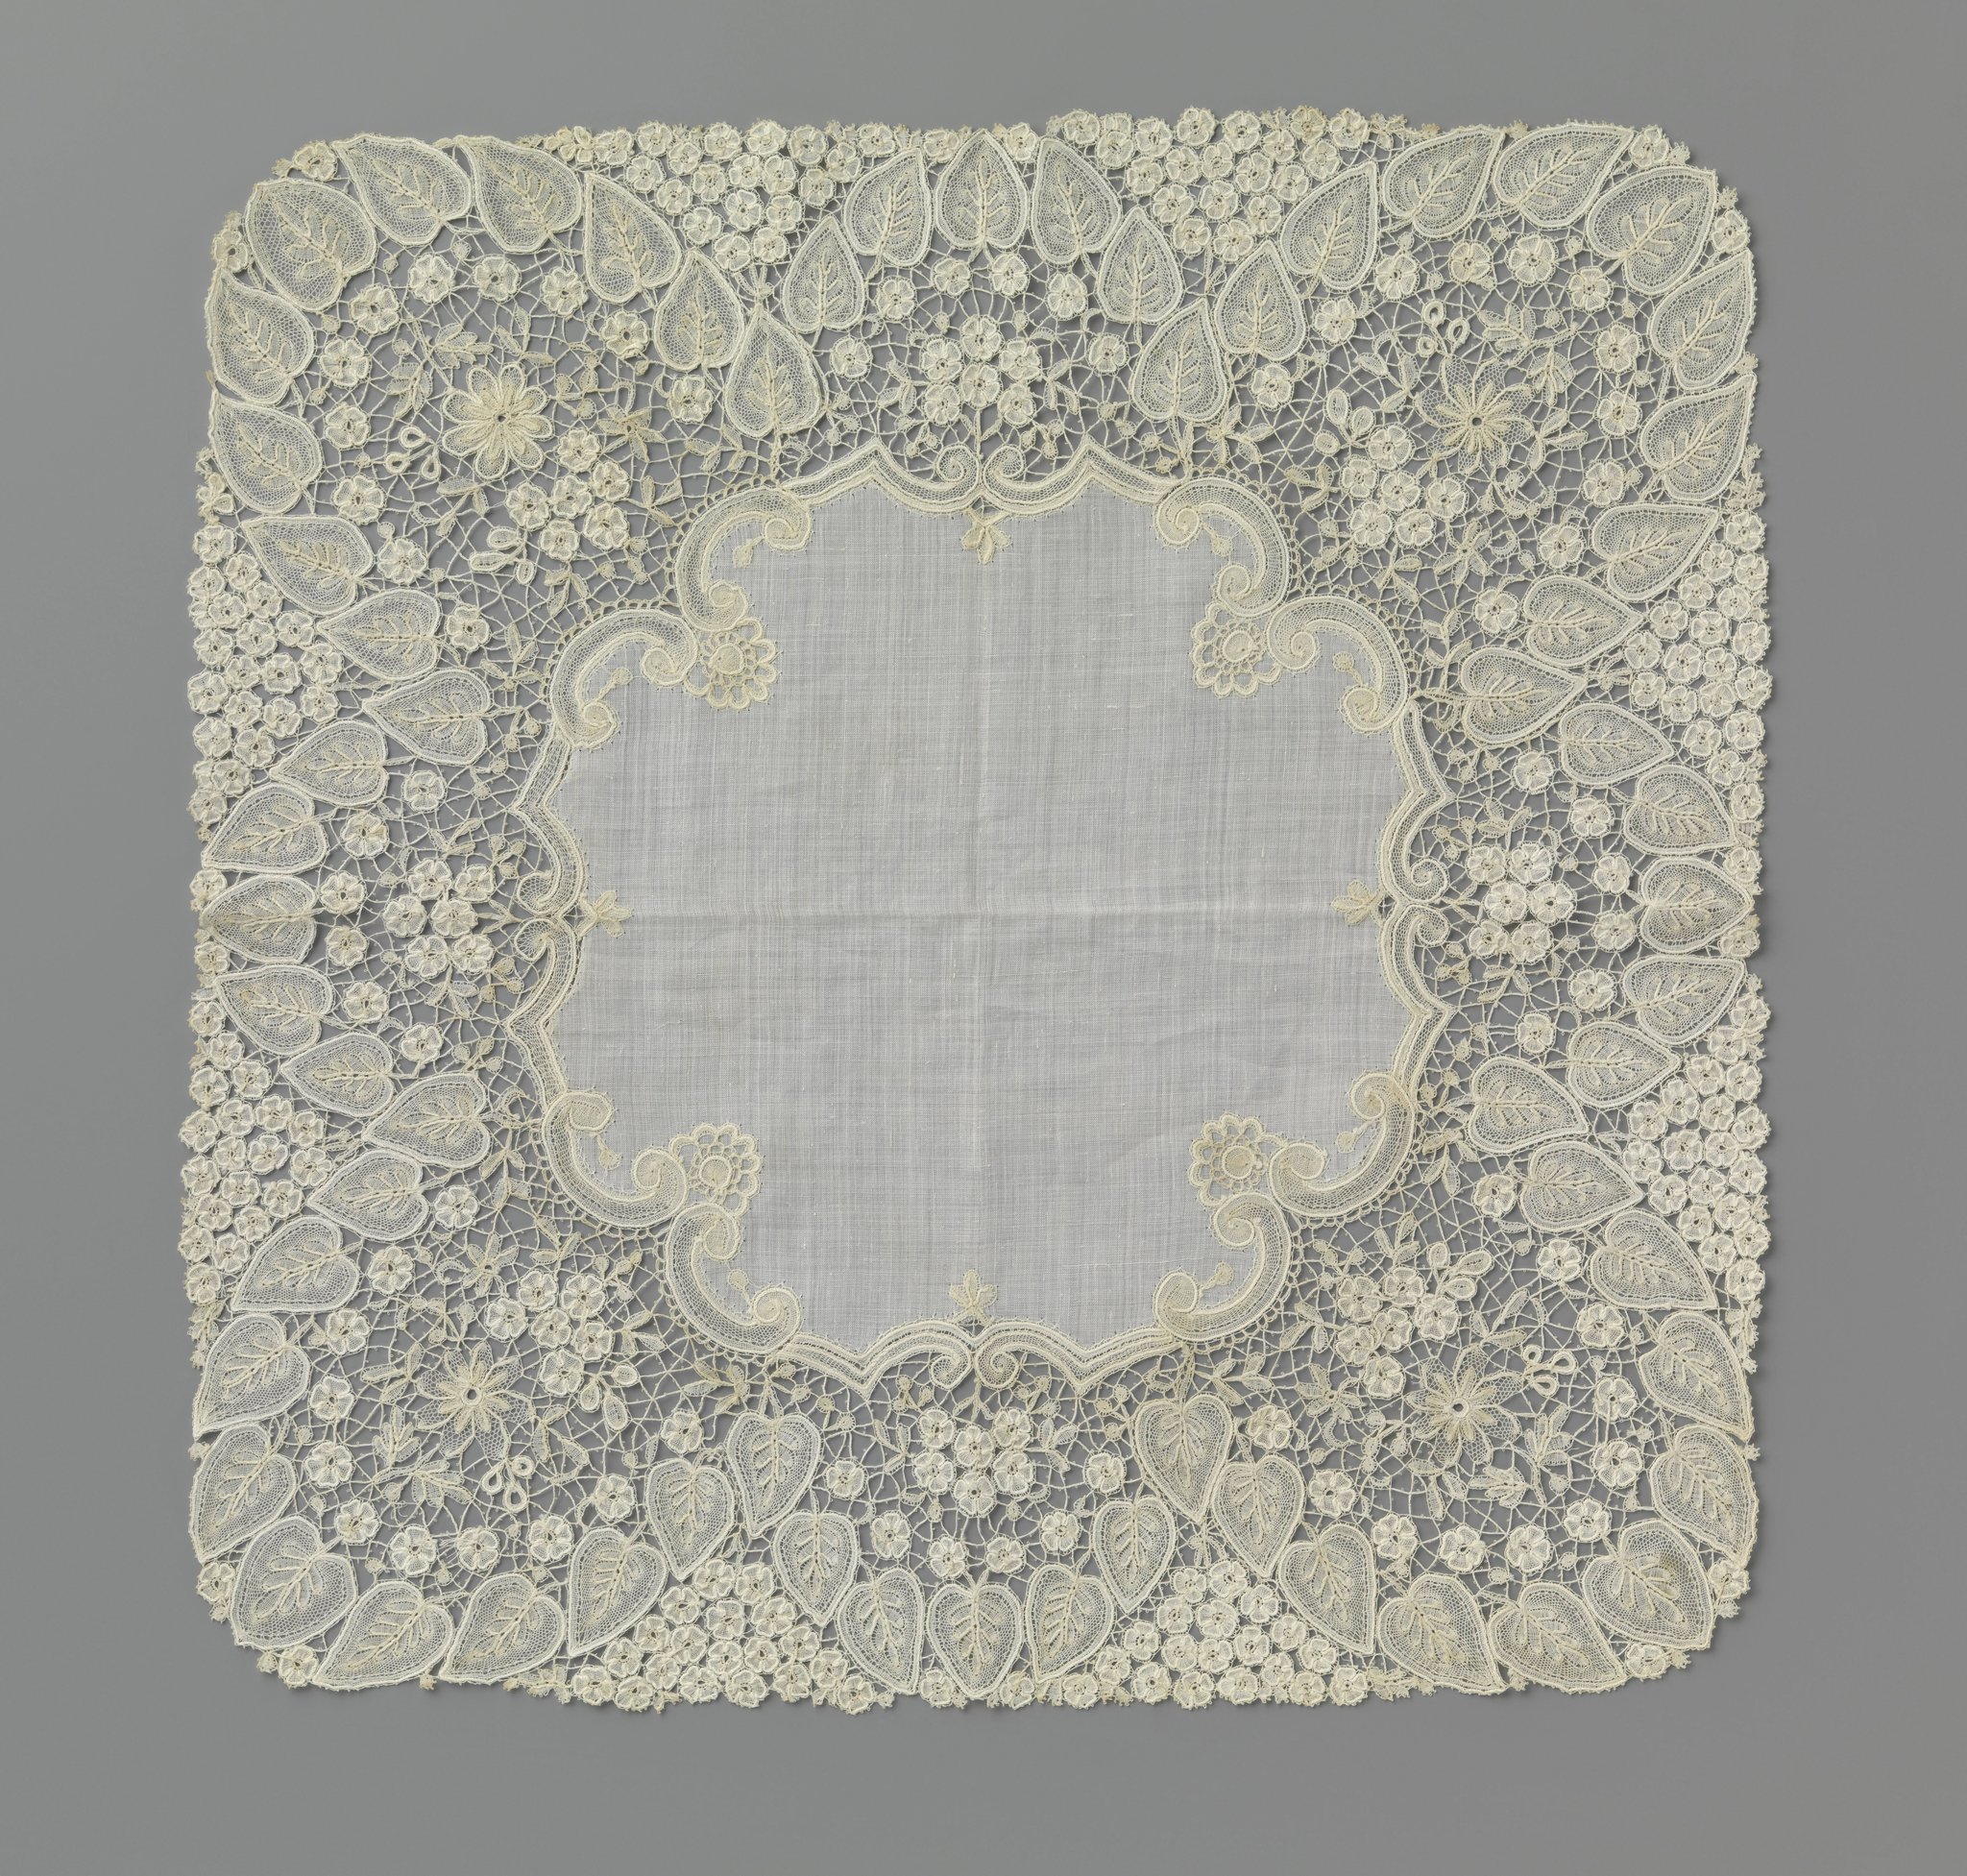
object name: handkerchief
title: Zakdoek met een rand van kloskant met seringenblaadjes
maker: Anonymous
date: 1900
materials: linen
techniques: lace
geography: brussels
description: Zakdoek met een gelobd batisten middenstuk en een rand van naturelkleurige kloskant: duchesse-kant. Rondom een gelobd batisten middenstukje loopt een rand kant met een open vlechtengrond. Een symmetrisch patroon vertoont acht grote, diepe schulpen die uit een slinger van hangende seringeblaadjes zijn opgebouwd. Hierbinnen staat een margrietje tussen losse bloesems. In de zwikken staan trossen van seringenbloemen, waardoor een afgeronde, nagenoeg vierkante omtrek is ontstaan.